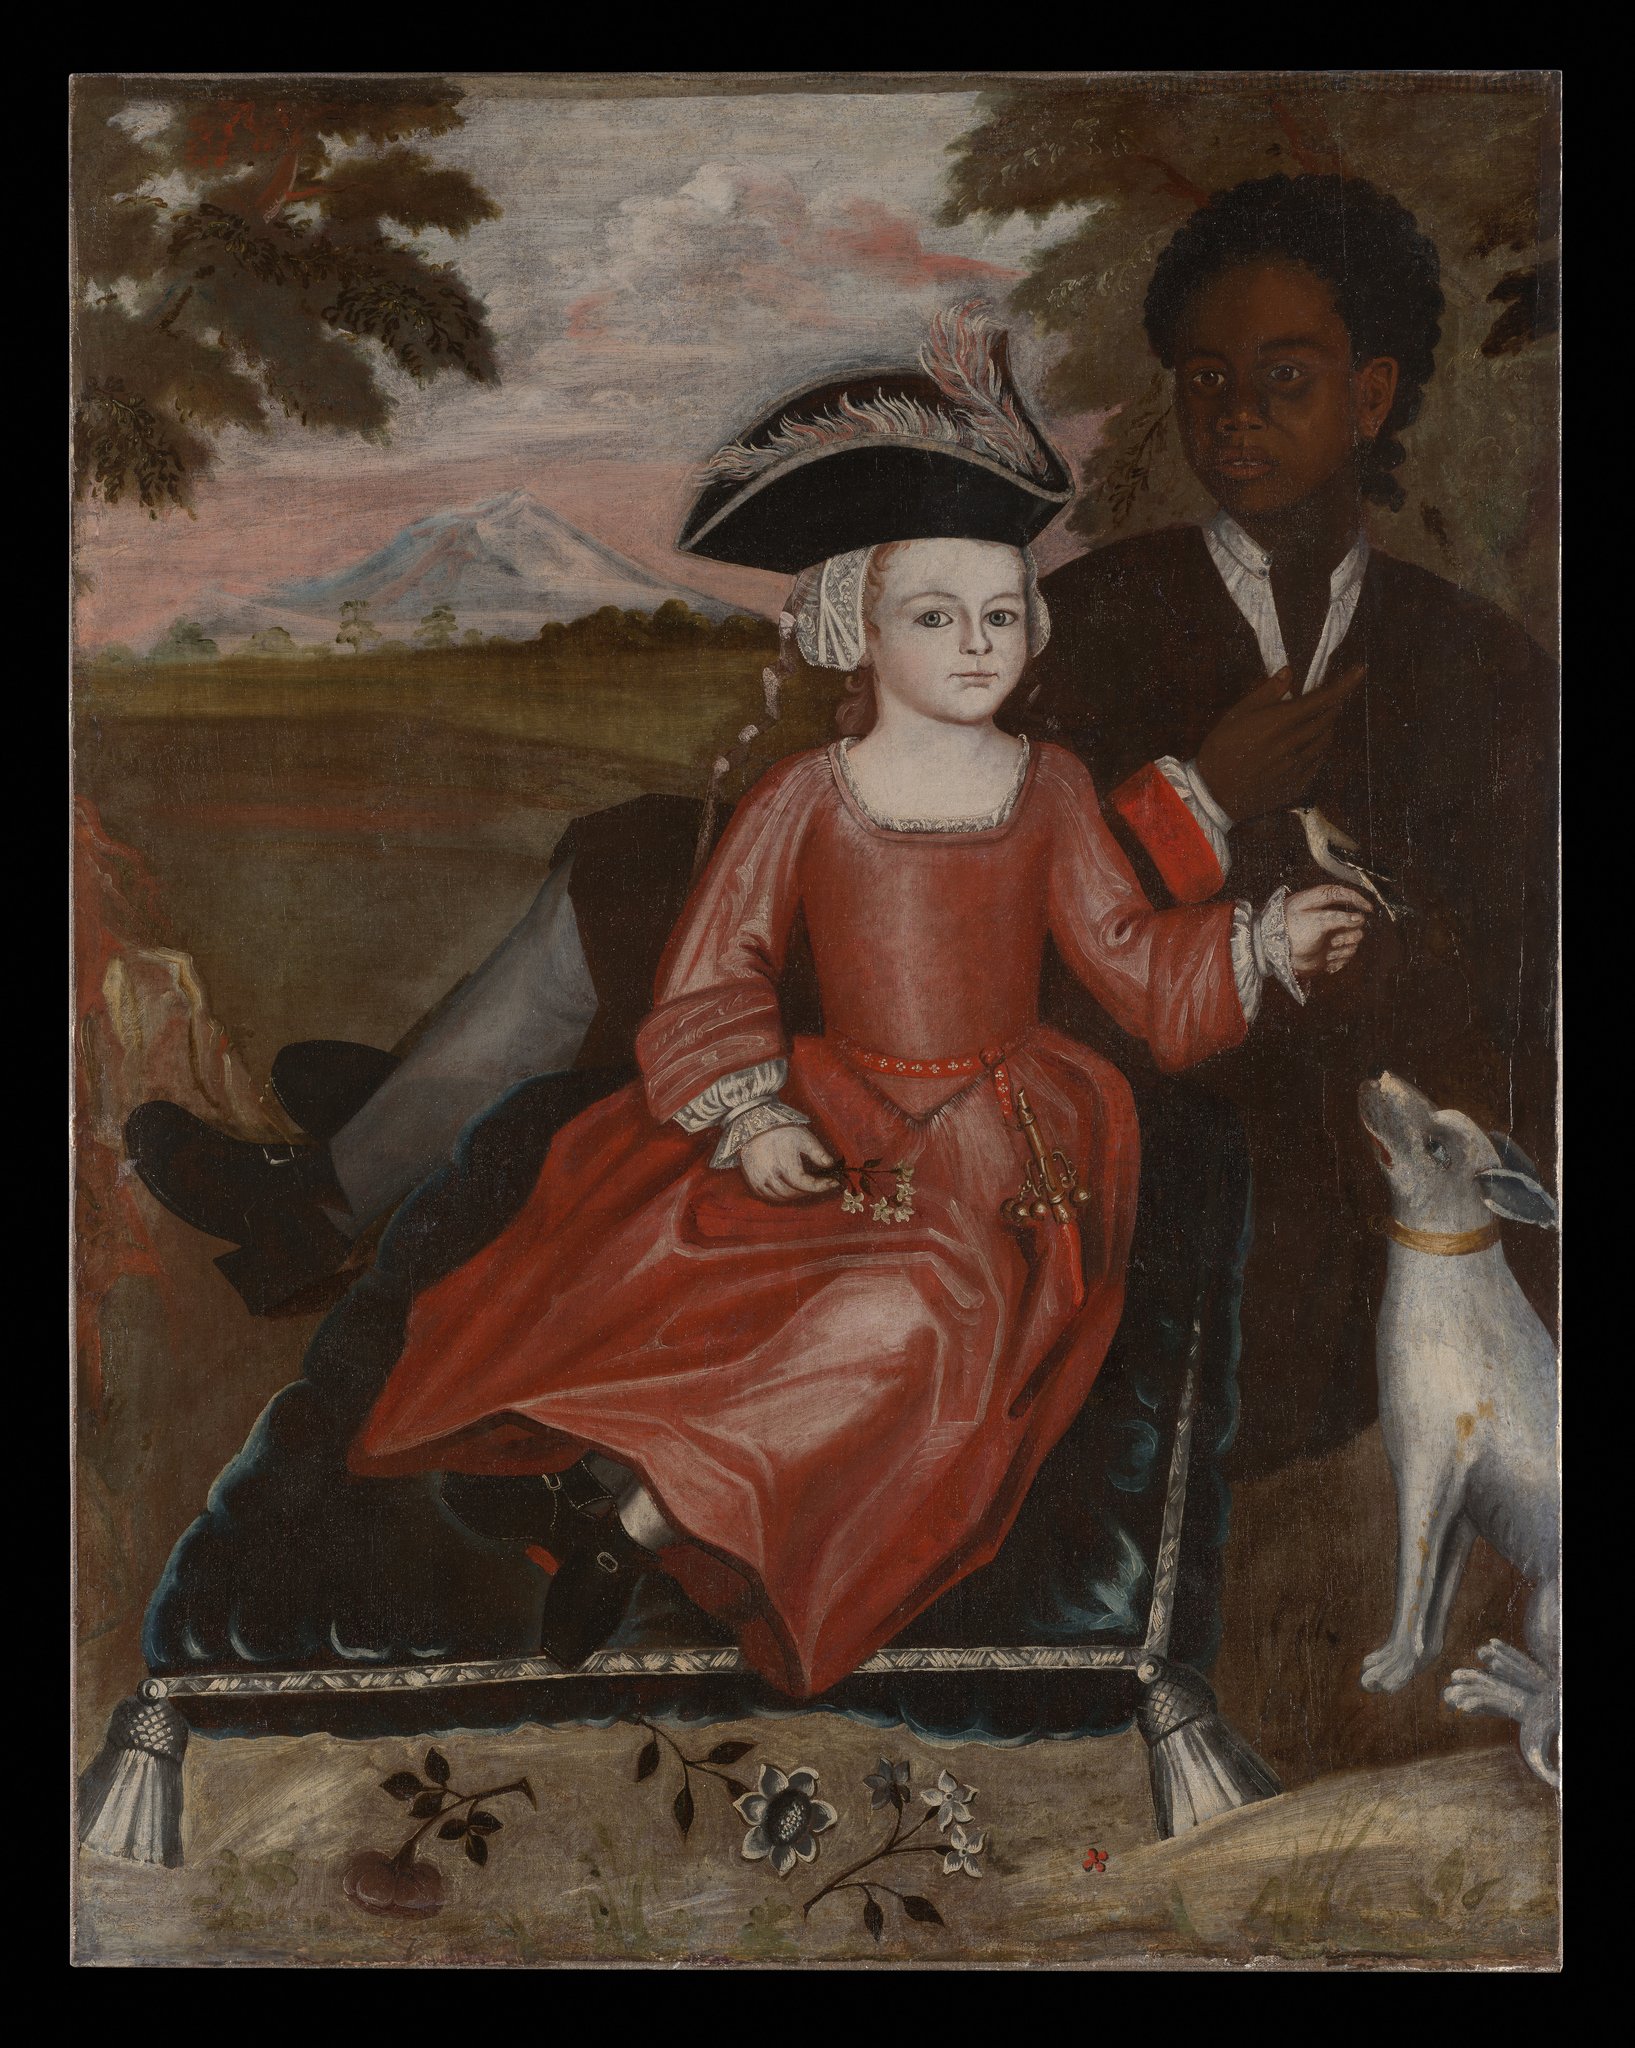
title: Child of the Van Rensselaer Family with Servant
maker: john heaton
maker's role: artist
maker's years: 1730-1745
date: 1730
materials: canvas, oil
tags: children,portraits,servants